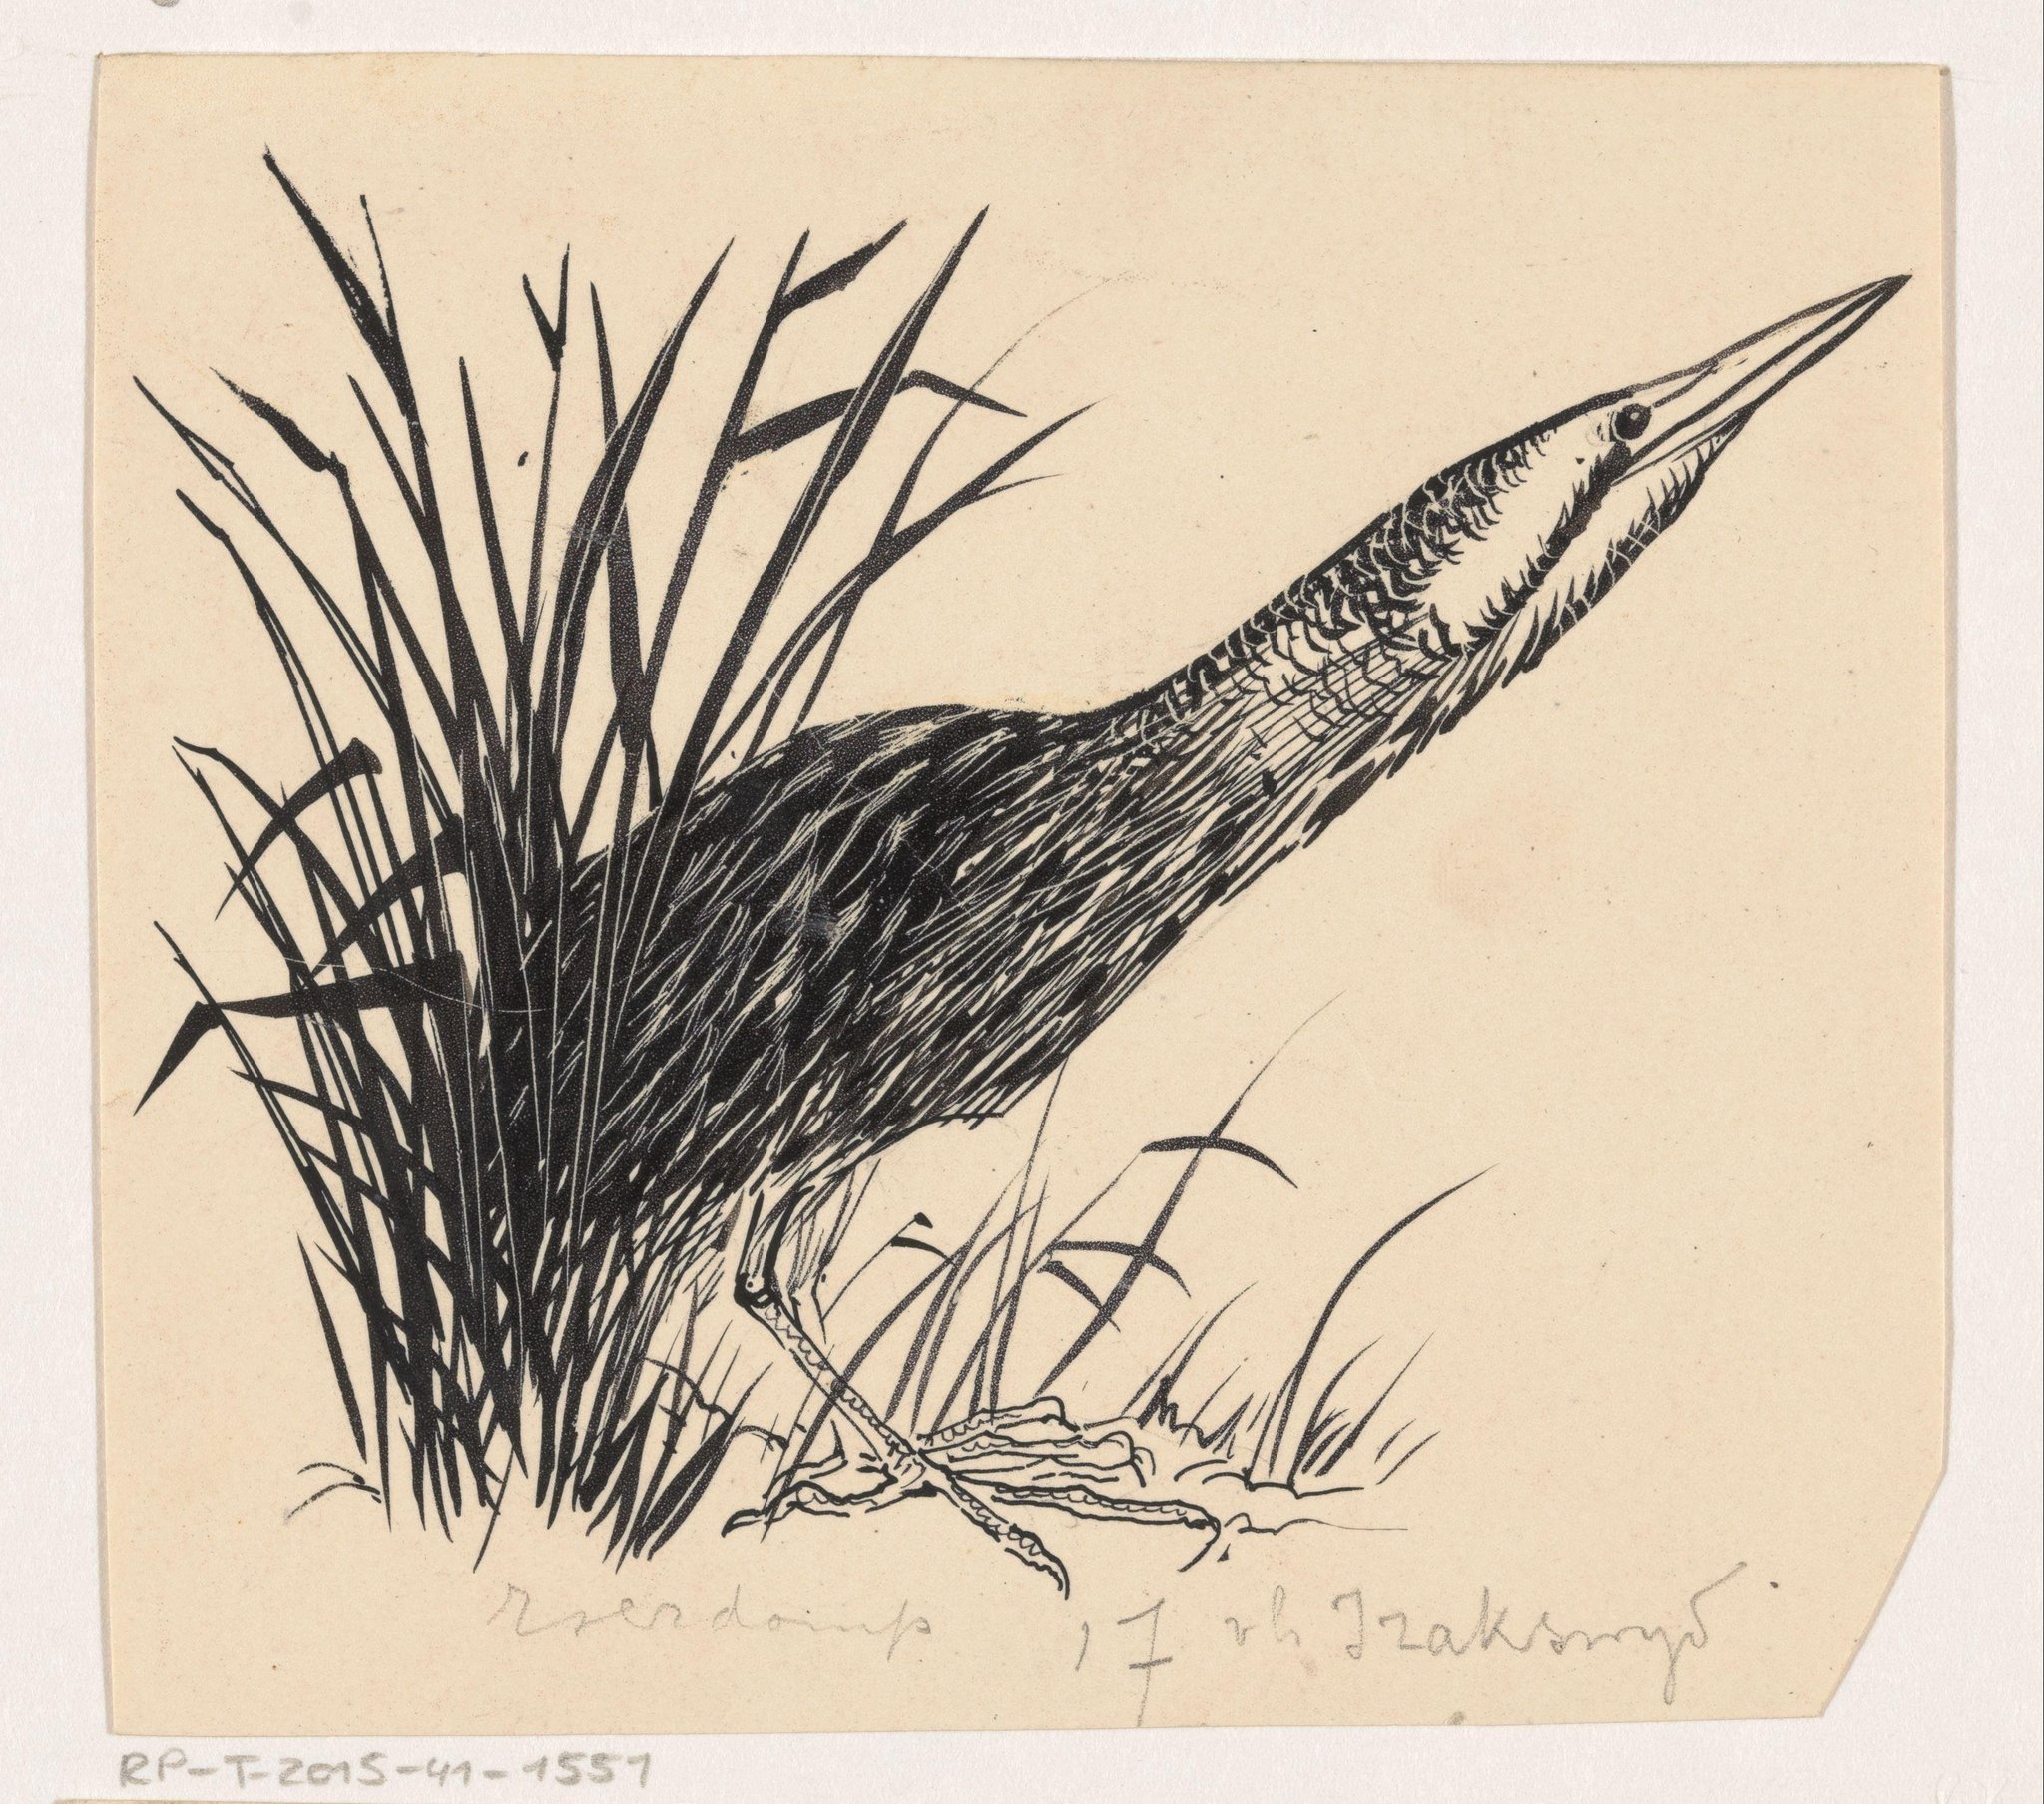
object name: boekillustratie ontwerp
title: Roerdomp in het riet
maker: henri verstijnen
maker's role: draughtsman, print maker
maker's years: 1882-1940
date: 1892-1940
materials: ink, paper, pencil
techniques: pen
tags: birds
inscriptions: :, annotation: ‘Roerdomp’, collector's mark: Lugt 2228, annotation: ‘roerdomp 17 vh Izaks[...]ijd’